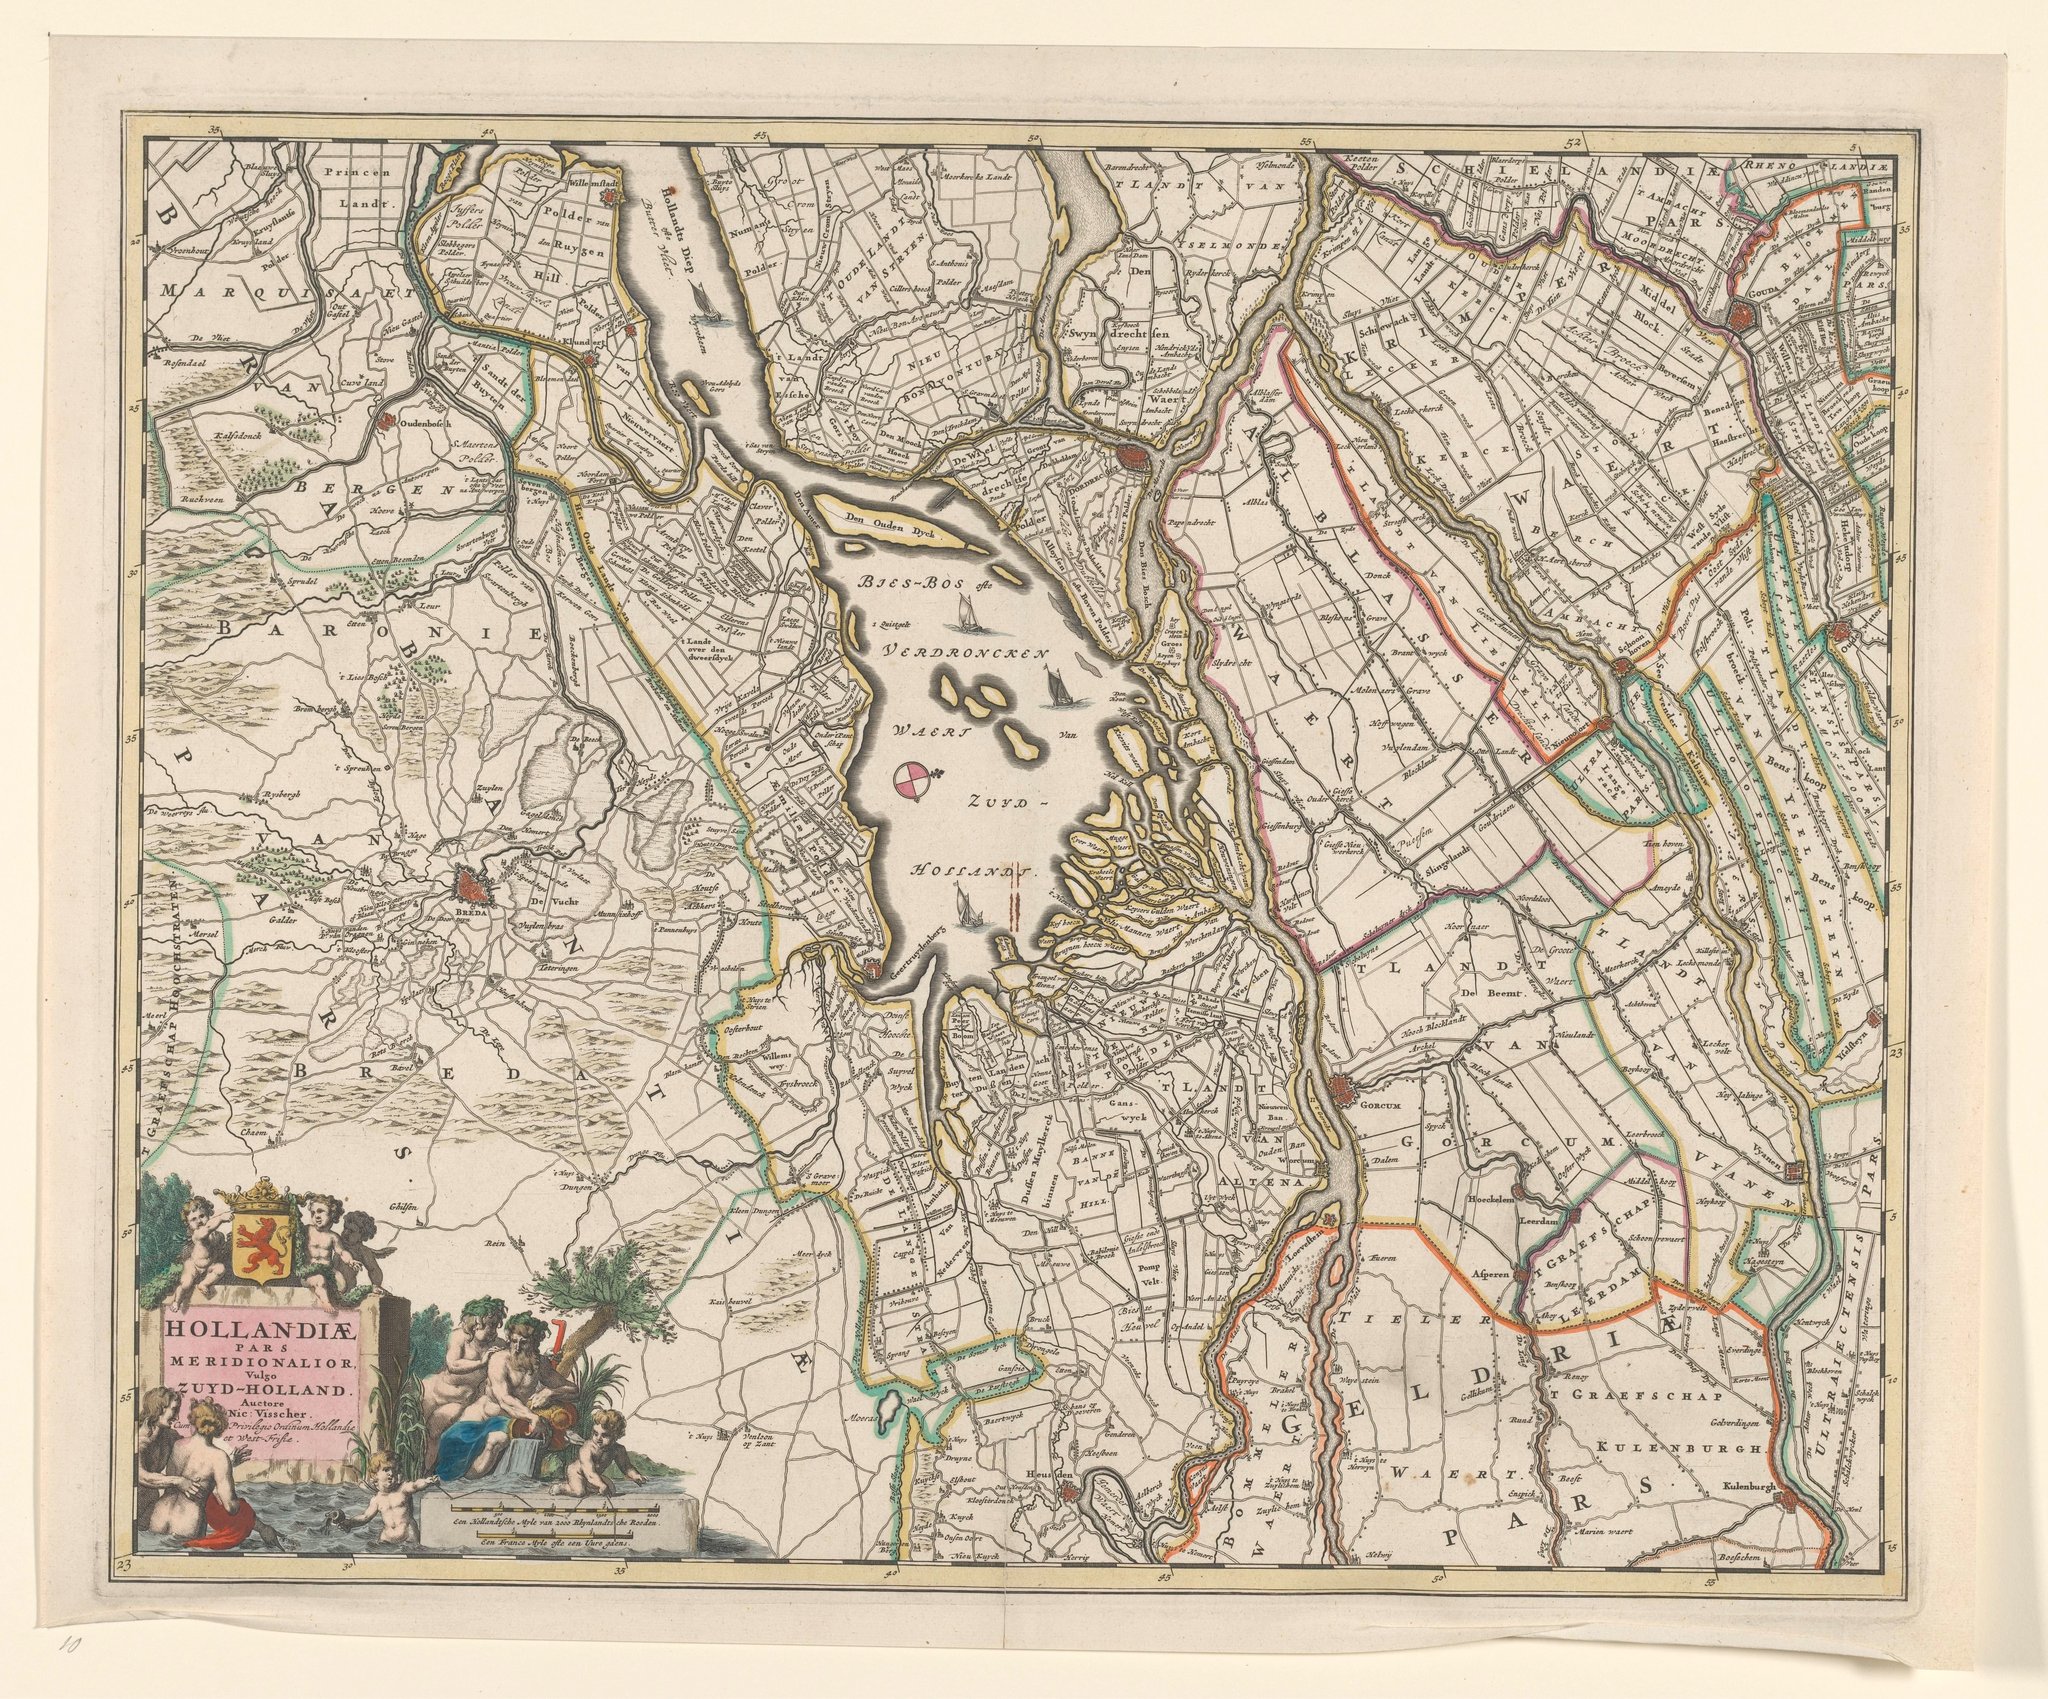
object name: map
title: Hollandiae pars meridionalior, vulgo Zuyd-Holland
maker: nicolaes visscher (i)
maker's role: print maker, publisher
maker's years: 1618-1679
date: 1680-1690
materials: paper, watercolor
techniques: engraving, hand coloring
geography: amsterdam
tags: maps of separate countries or regions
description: Kaart van omgeving van de Biesbos in Zuid-Holland. Linksonder een cartouche met de titel en drie putti met gekroond wapenschild van Holland. Daarvoor water met man en vrouw erin wadend en ernaast zittende vrouw en man met kruik waaruit water stroomt. Op de voorgrond een steen met de schaal in Hollandse en Franse mijlen met twee putti die een duimstok vasthouden (1:170.000).